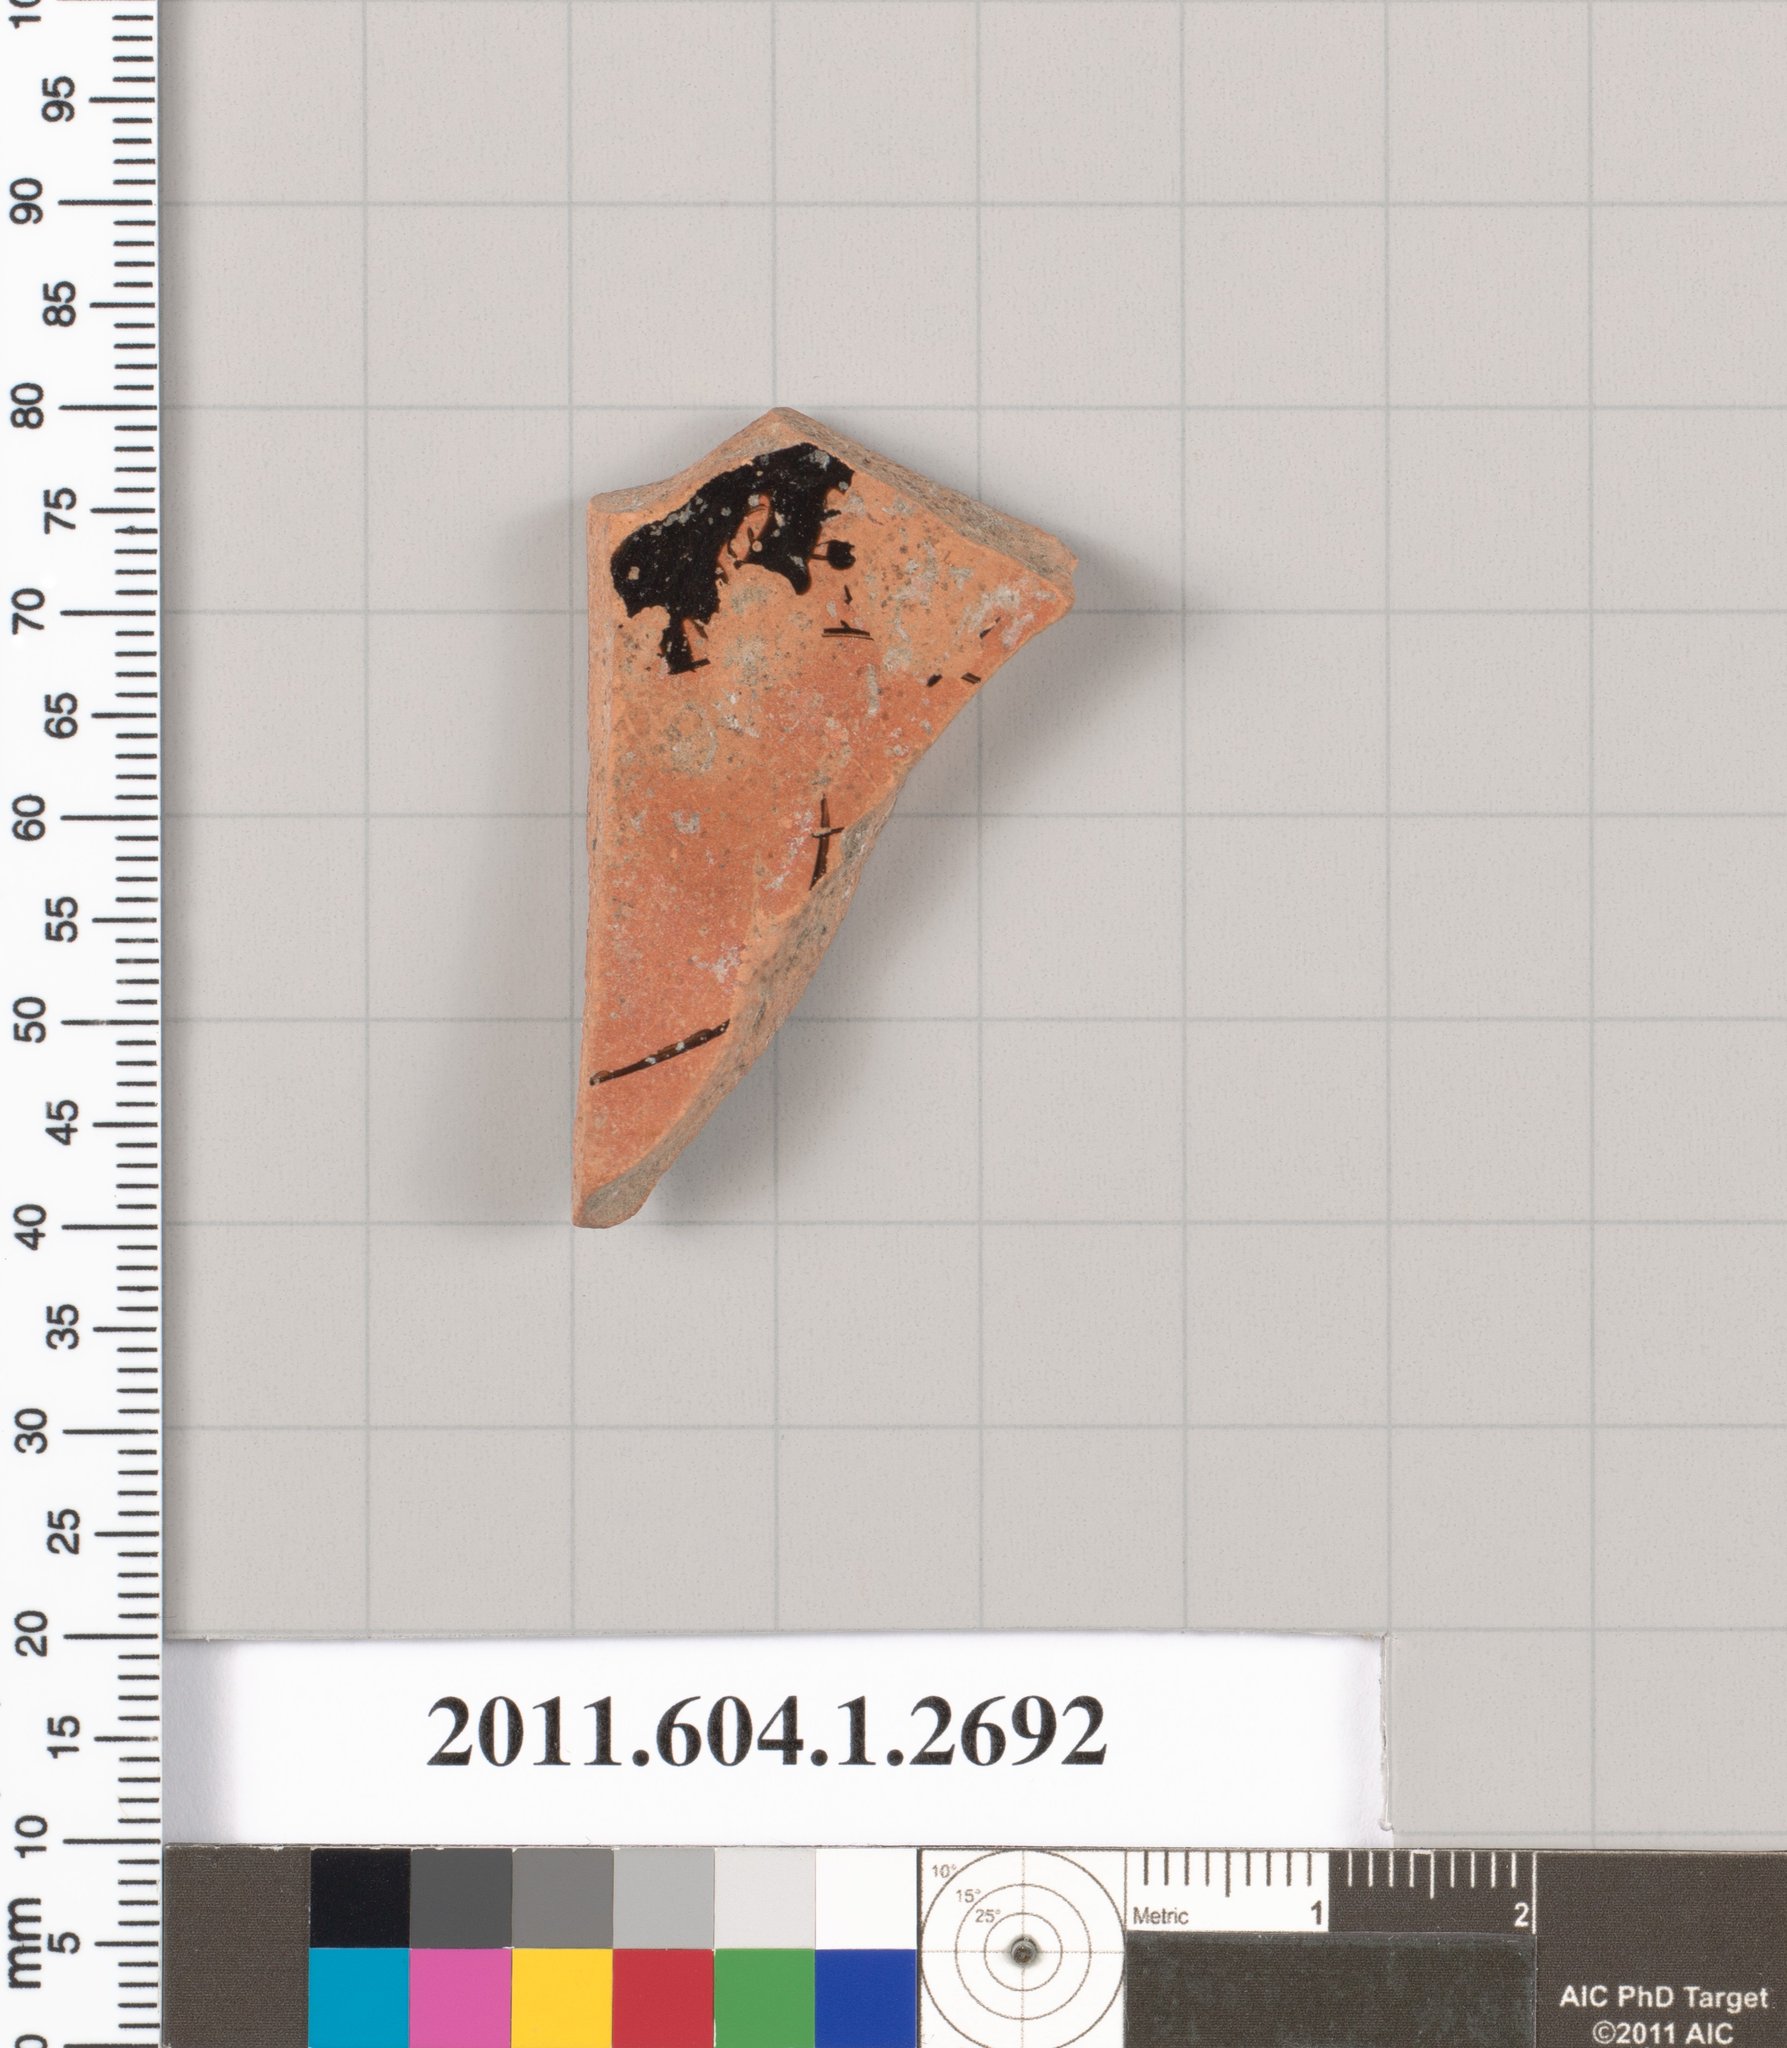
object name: kylix fragment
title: Terracotta fragment of a kylix (drinking cup)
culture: greek, attic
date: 475-451 BCE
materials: terracotta